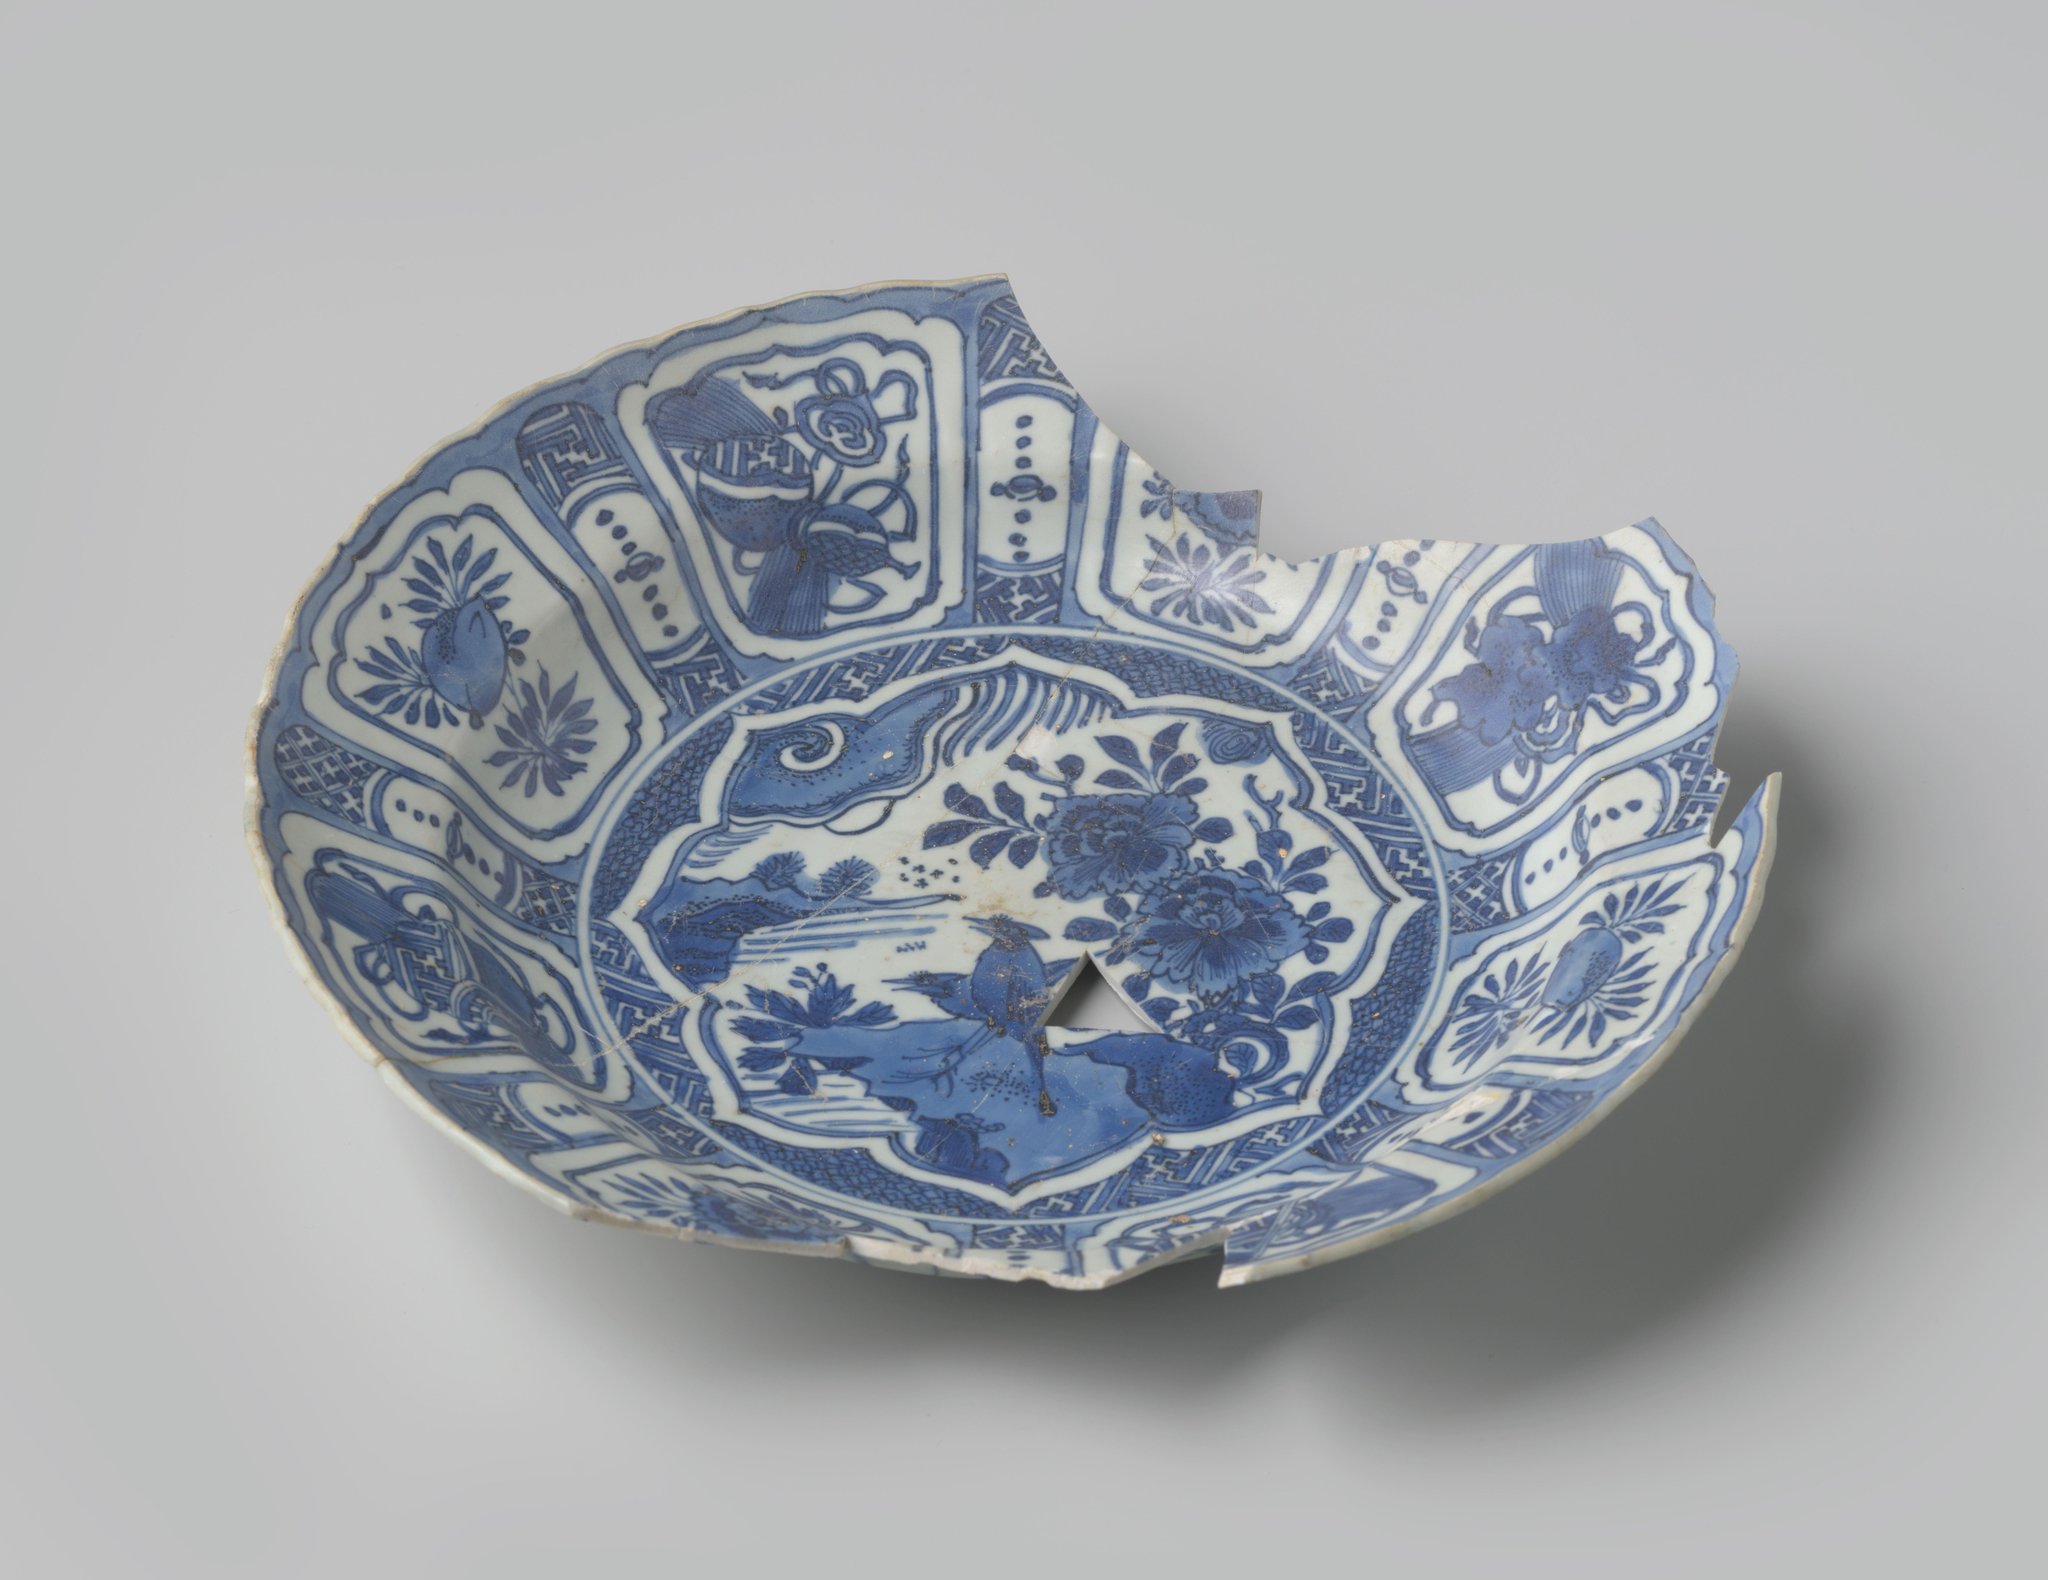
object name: sherd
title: Bord uit V.O.C.-schip de 'Witte Leeuw'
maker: Anonymous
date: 1613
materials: bone china, porcelain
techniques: painted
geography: jingdezhen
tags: verenigde oostindische compagnie, sint-helena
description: A plate with a flattened rim. A scalloped medallion filled with alternating diaper patterns. A central decoration of two birds in a marsh landscape. Panels decorated with fruits and symbols.